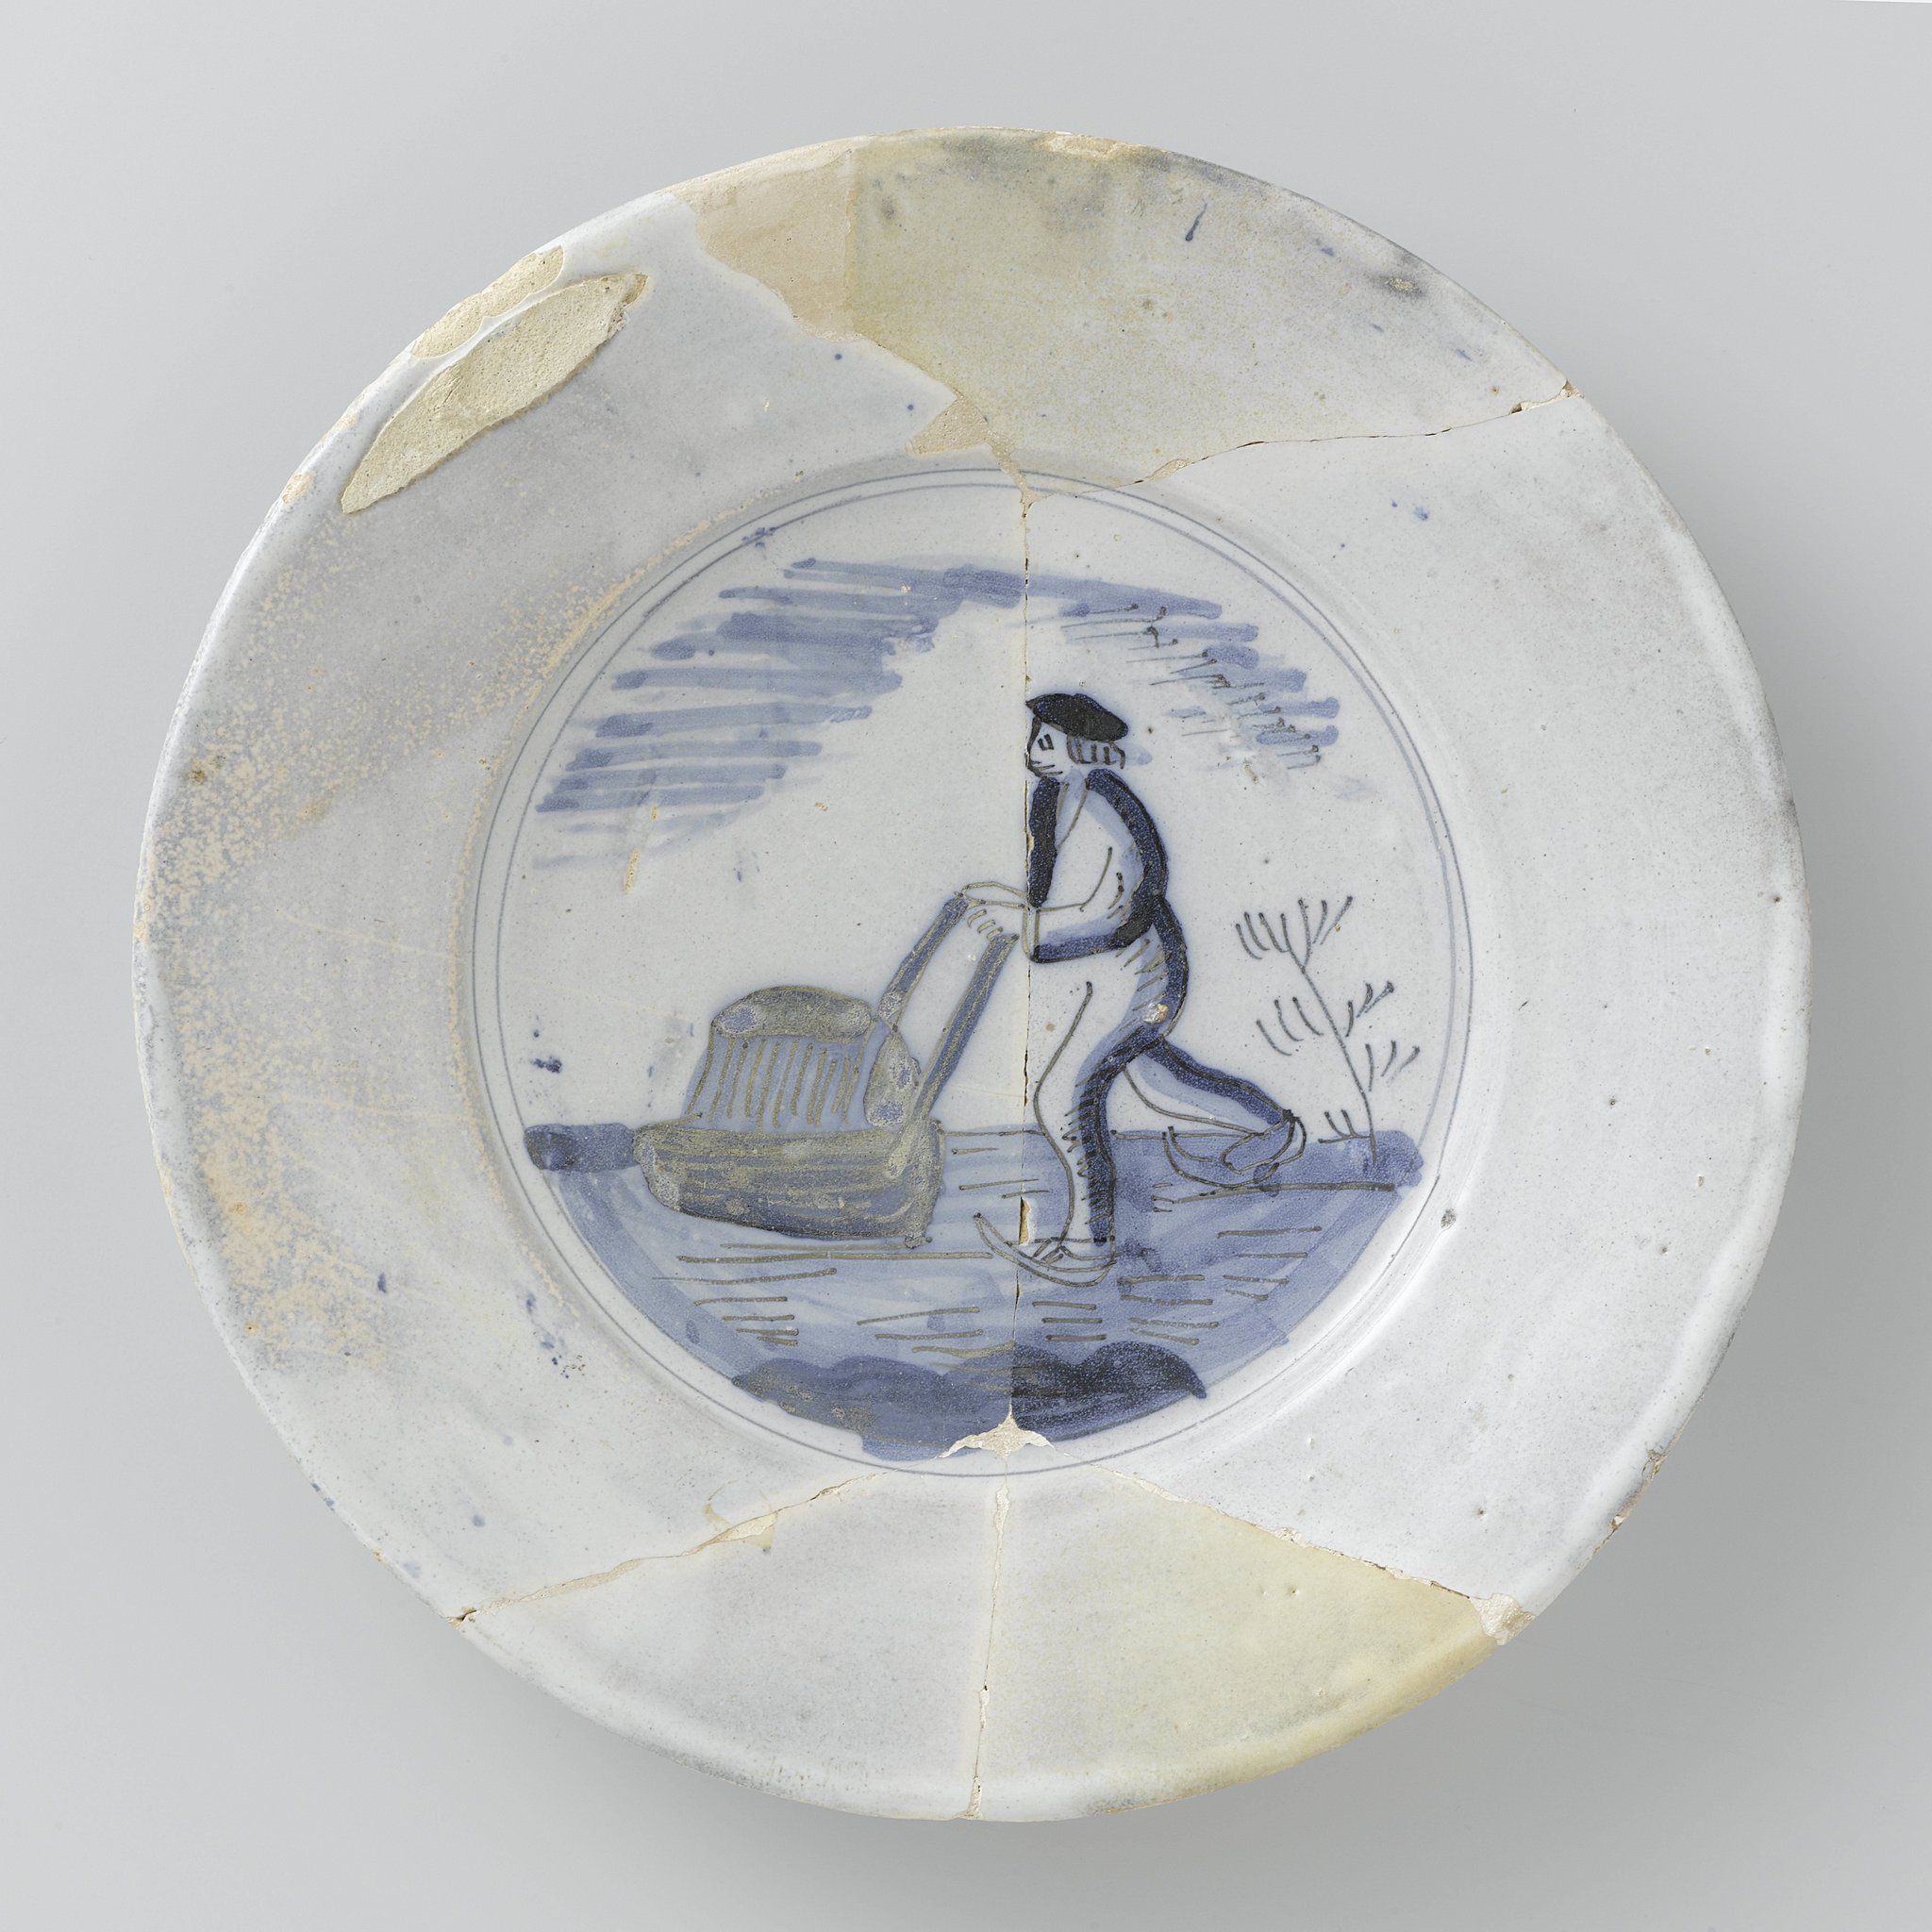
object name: plate dish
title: Bord met in blauw voorstelling van een schaatsende man die een slede voortduwt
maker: Anonymous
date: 1660-1680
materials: earthenware, glaze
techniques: painted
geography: delft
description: bodemvondst. gerestaureerd (inventariskaart) De streep van ongeglazuurd aardewerk, die op de rand van het bord zit, is een fout die in de oven is ontstaan. Het bord is vermoedelijk als 'tweede keuze' voor een lagere prijs verkocht. (mondelinge mededeling Pier Terwen 26-04-2019). Het bord is vermoedelijk opgegraven door Theo van Halderen in Delft.